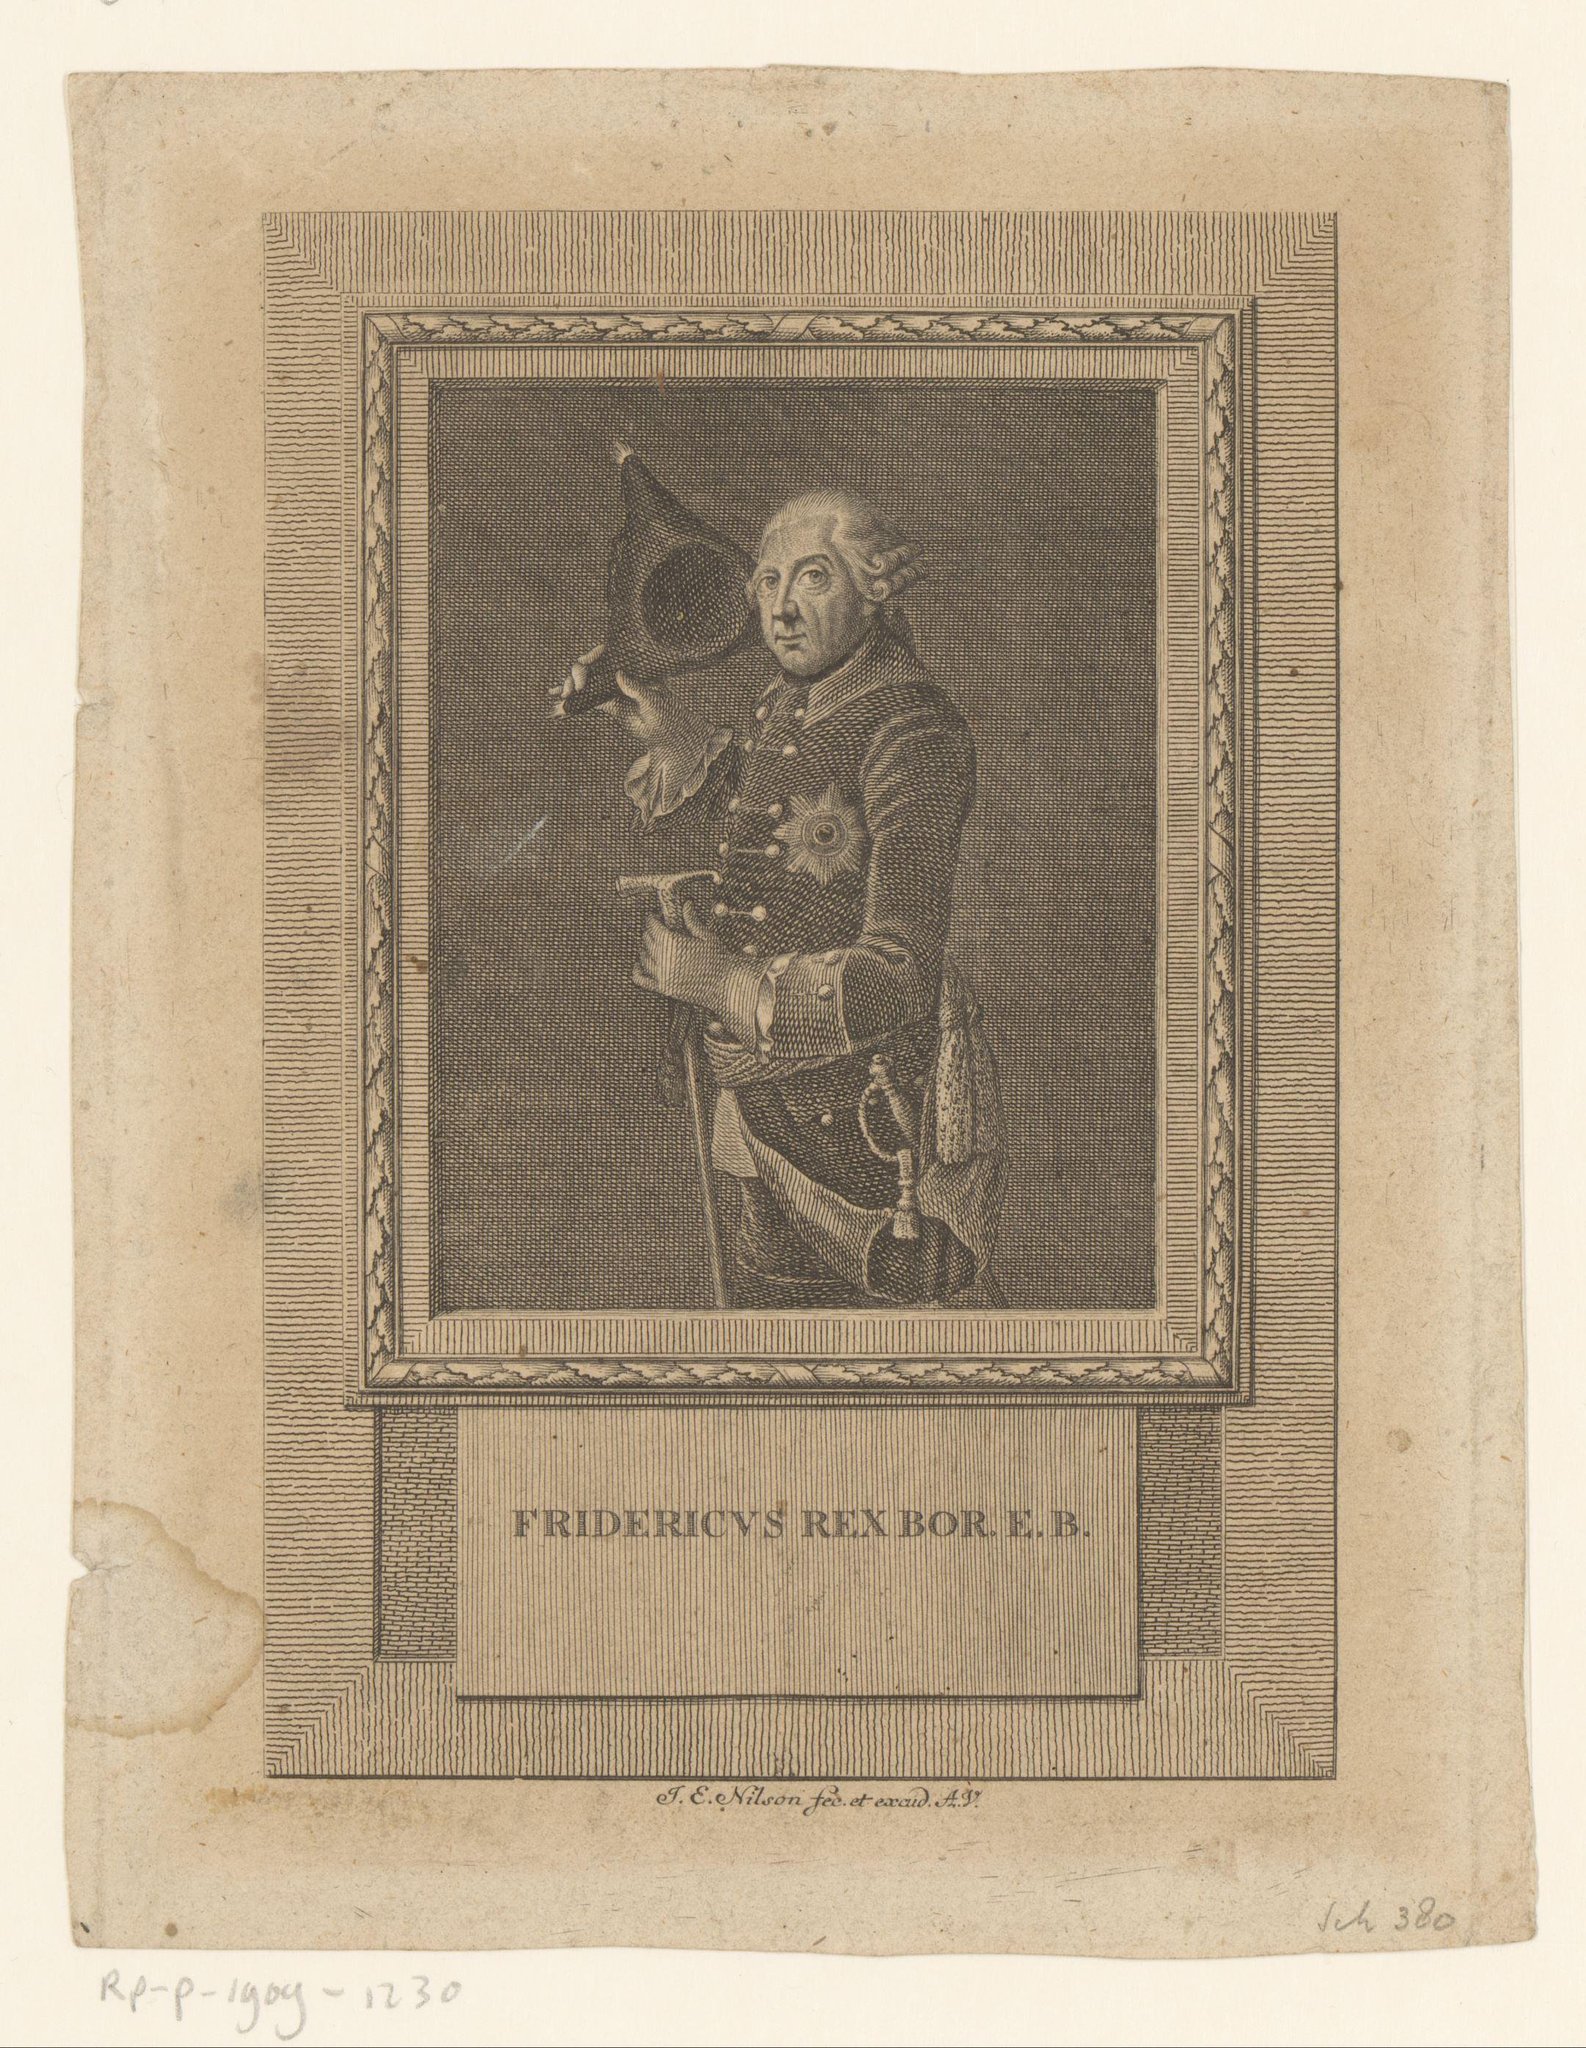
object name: print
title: Portret van Frederik de Grote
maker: johann esaias nilson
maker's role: draughtsman, print maker, publisher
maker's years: 1721-1788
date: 1740-1788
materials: paper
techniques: engraving, etching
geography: augsburg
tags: berlin, frederick ii (king of prussia), knighthood order (with name) - insignia of a knighthood order, e.g.: badge, chain (with name of order), walking-stick, staff, historical persons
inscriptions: collector's mark: Lugt 2228